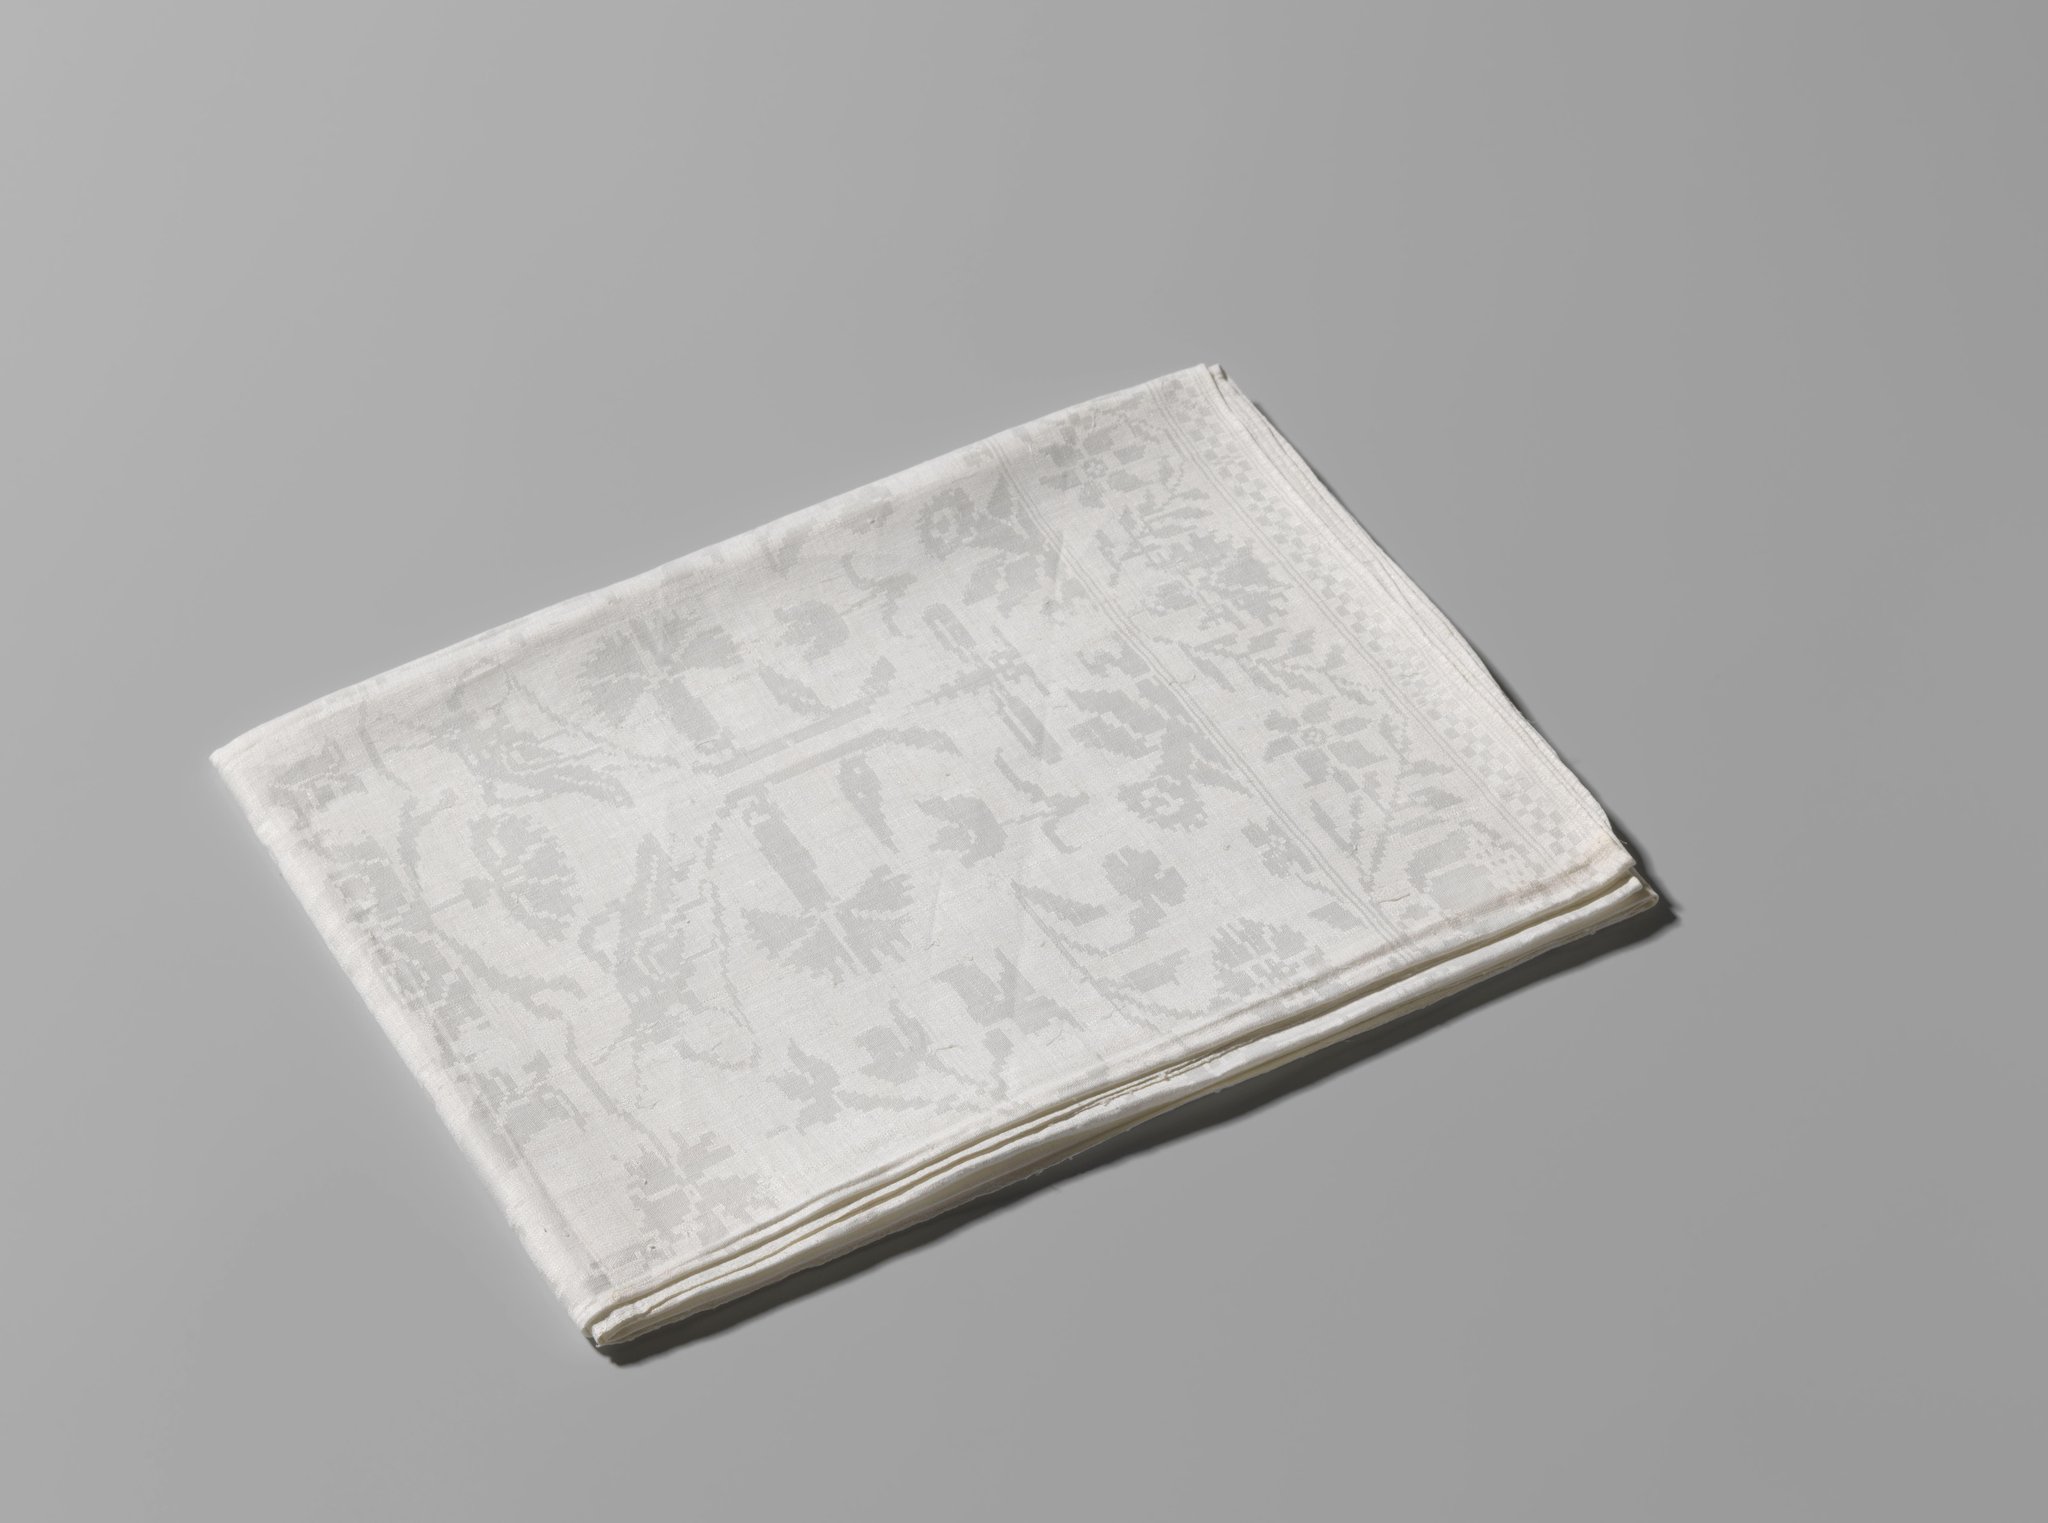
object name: woven material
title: Servet van wit linnendamast met de gekoppelde wapens Von Inn- und Kniphausen en Van Ewsum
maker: Anonymous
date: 1665-1670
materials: linen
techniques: damask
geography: northern netherlands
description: Servet van wit linnendamast met bloempatroon romdom de gekoppelde wapens Von Inn- und Kniphausen en Van Ewsum. Gemerkt: kroon LE 17.